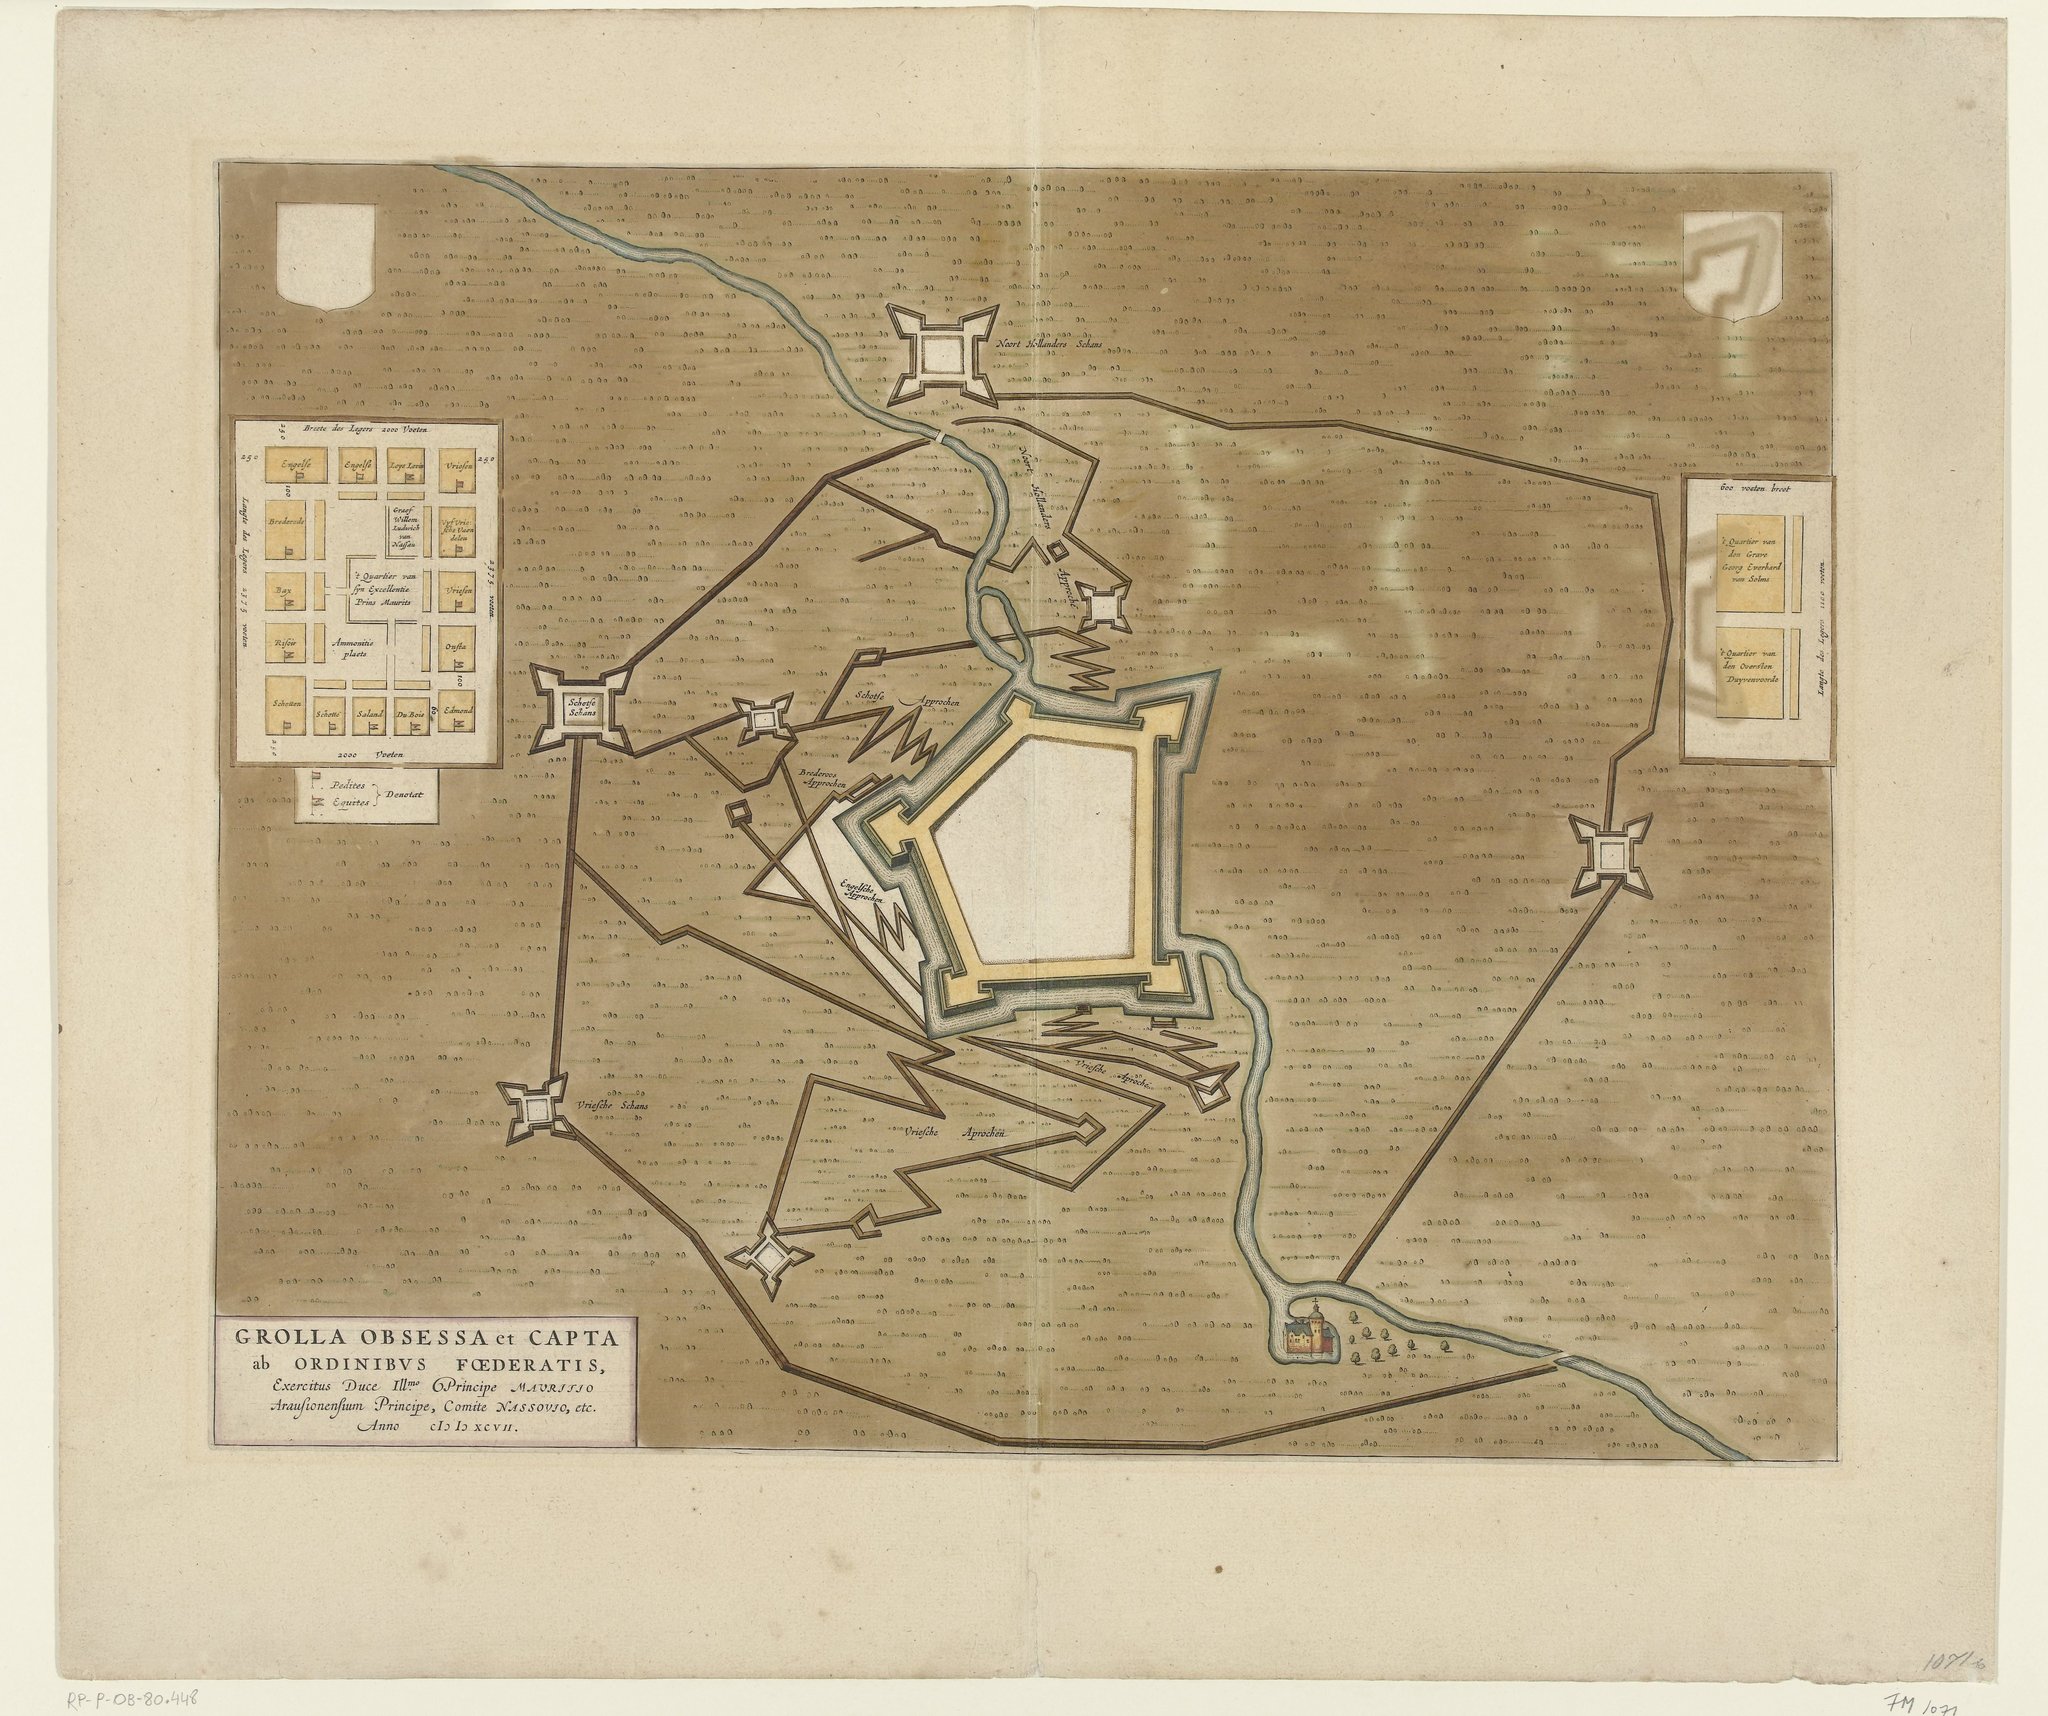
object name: print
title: Grolla obsessa et capta ab ordinibus foederatis, Excercitus Duce Ill.mo Principe Mauritio Arausionsium Principe, Comite Nassovio, etc. anno MDXCVII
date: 1652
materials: paper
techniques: etching, hand coloring, letterpress printing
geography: amsterdam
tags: the hague, maurice (prince of orange), maps of separate countries or regions, fortifications, military engineering, maps of cities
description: Beleg en verovering van Groenlo door Maurits, 28 september 1597. Kaart van de versterkingen van de stad Groenlo (Grol). Links het legerkamp van prins Maurits, rechts het kamp van de graaf van Solms. Op een dubbelblad genomen uit het Stedenboek van Blaeu, op de achterzijde tekst in het Nederlands en plattegronden en doorsneden van de schansen.